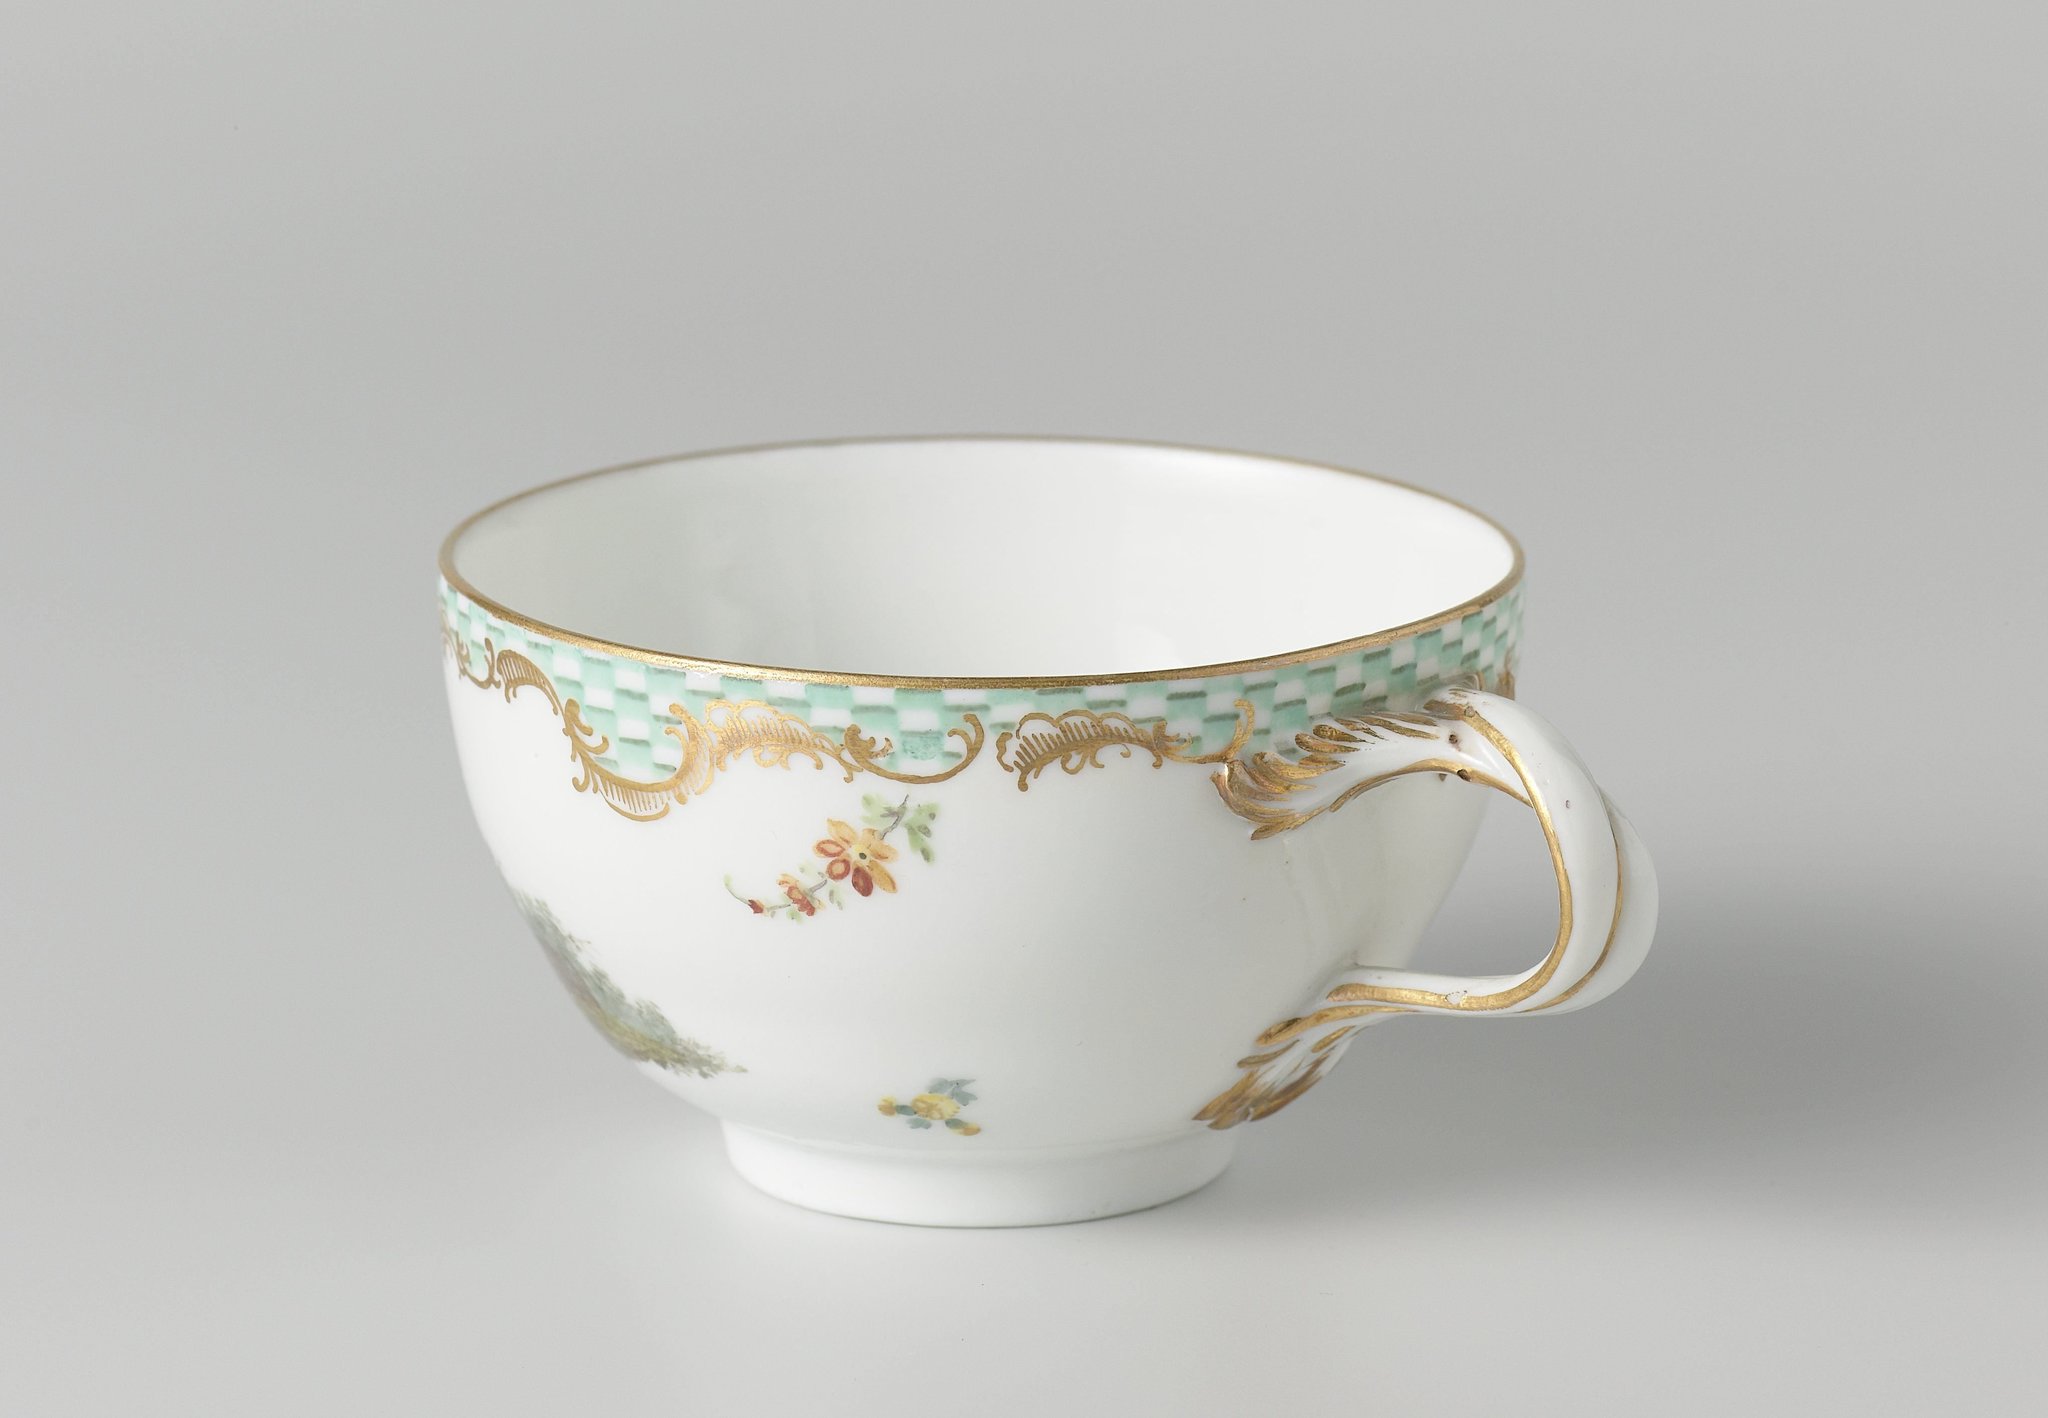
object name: cup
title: Kop, veelkleurig beschilderd met een landschap met figuren.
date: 1777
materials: porcelain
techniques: painted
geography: meissen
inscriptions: mold mark: ‘18’, factory mark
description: Lage kop met oor, van beschilderd porselein. De kop is beschilderd met landschappen waarin figuren en langs de rand een brede strook groen vlechtwerk. De kop is gemerkt.